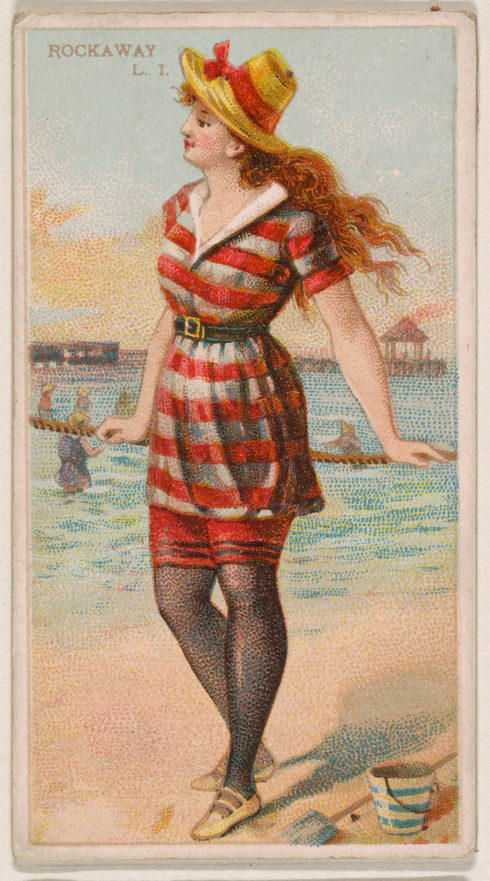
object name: print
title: Rockaway, Long Island, from the Surf Beauties series (N232), issued by Kinney Bros.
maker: kinney brothers tobacco company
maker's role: publisher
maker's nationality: american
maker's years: 1869-2011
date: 1889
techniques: color lithograph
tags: profiles,women